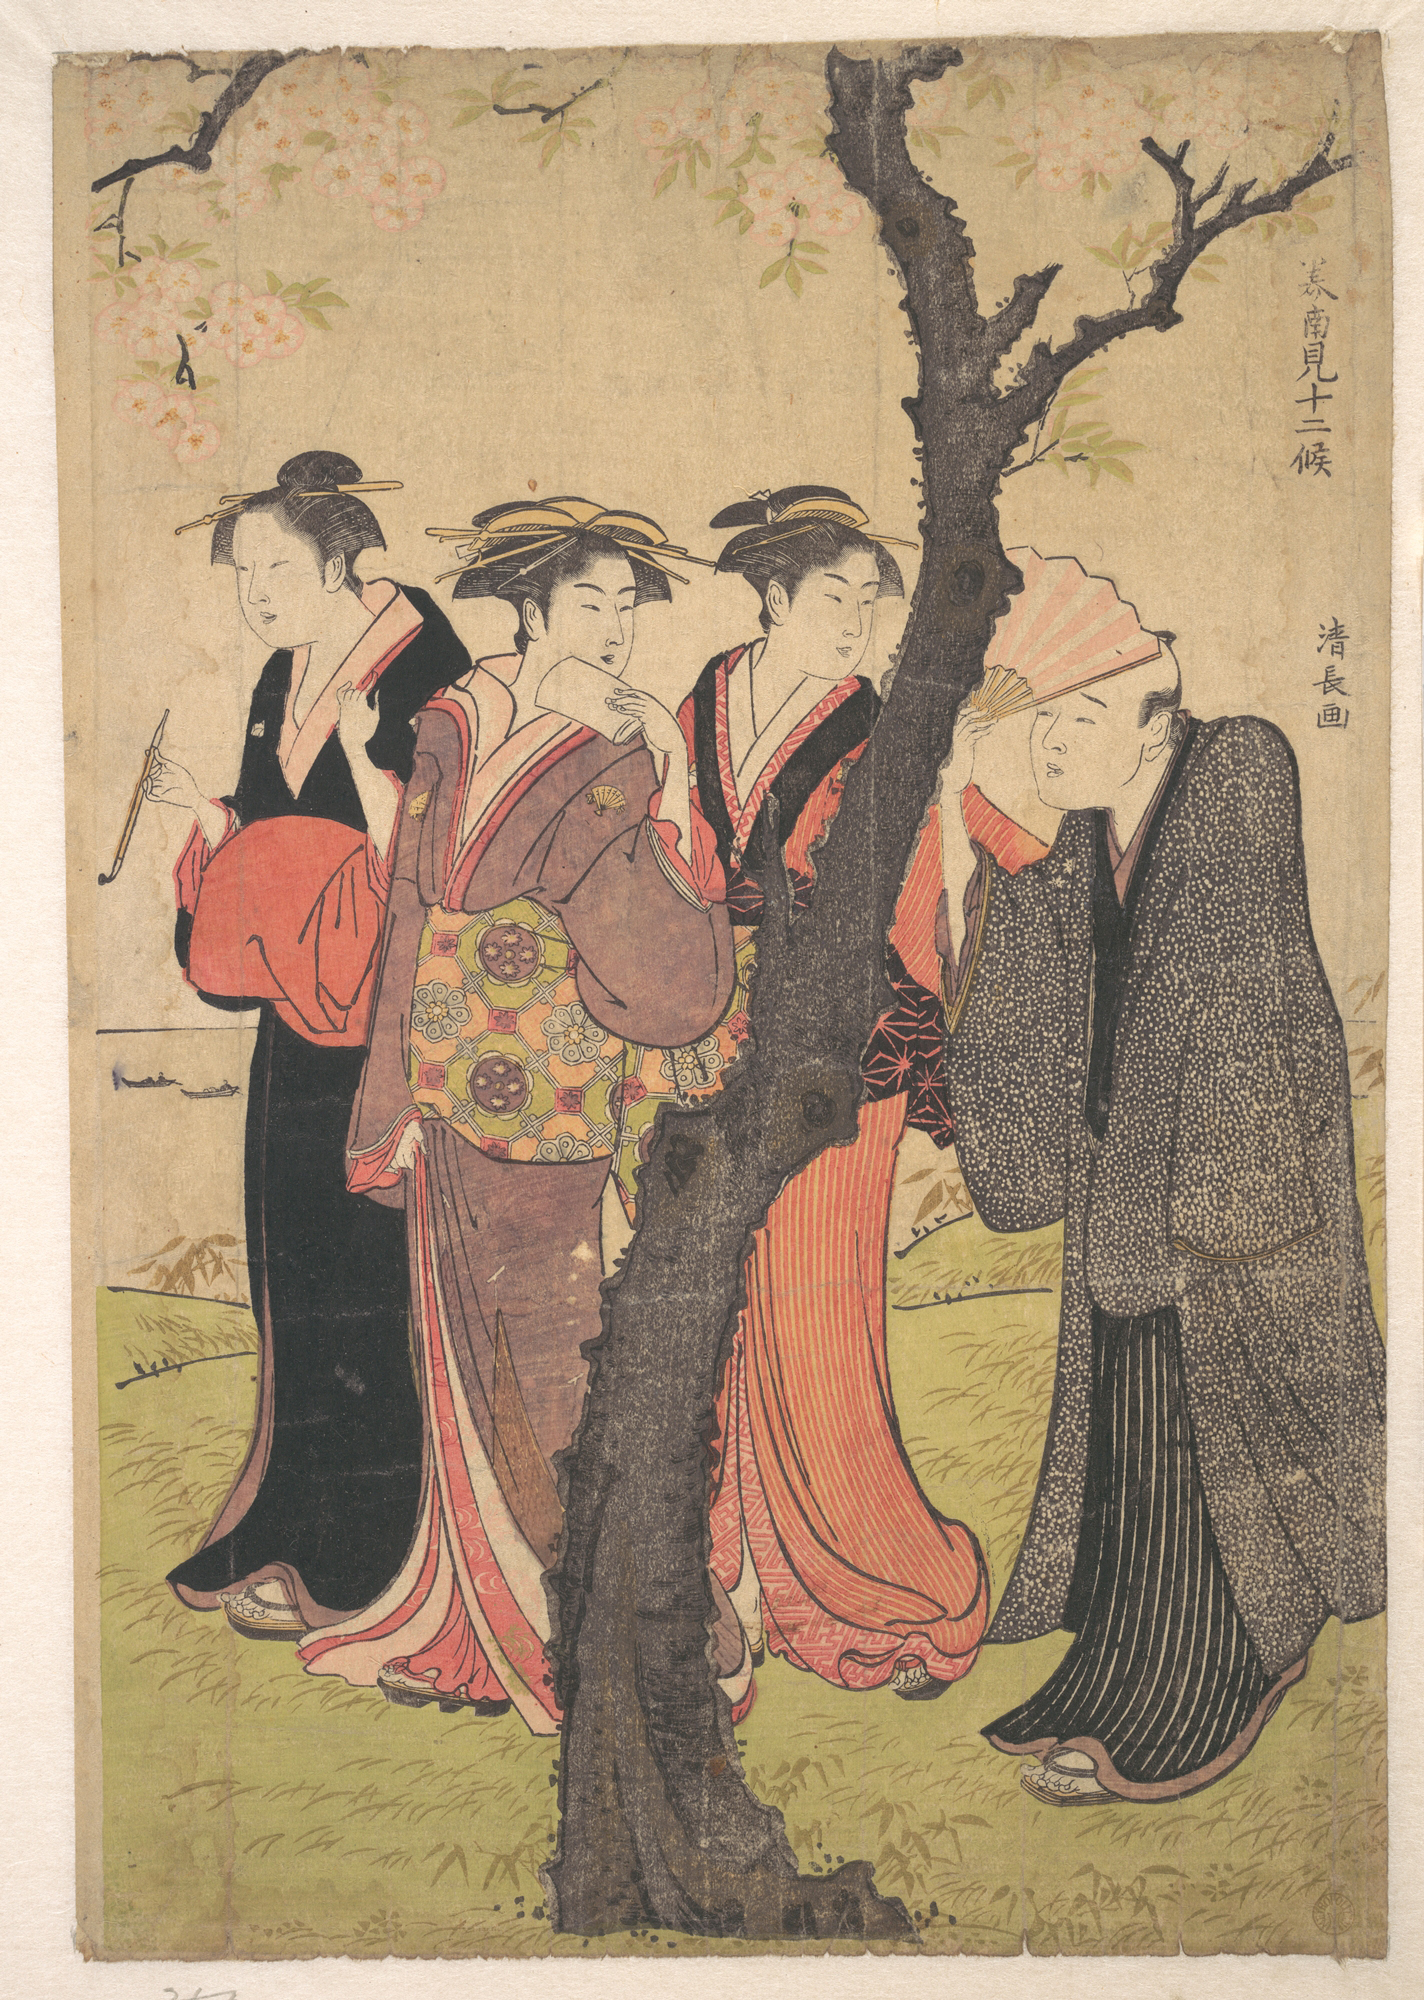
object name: print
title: Cherry Blosson Viewing at Gotenyama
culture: japanese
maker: torii kiyonaga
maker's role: artist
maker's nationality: japanese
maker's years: 1752-1815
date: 1784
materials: ink, paper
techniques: woodblock print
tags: fans,men,women,flowers,trees